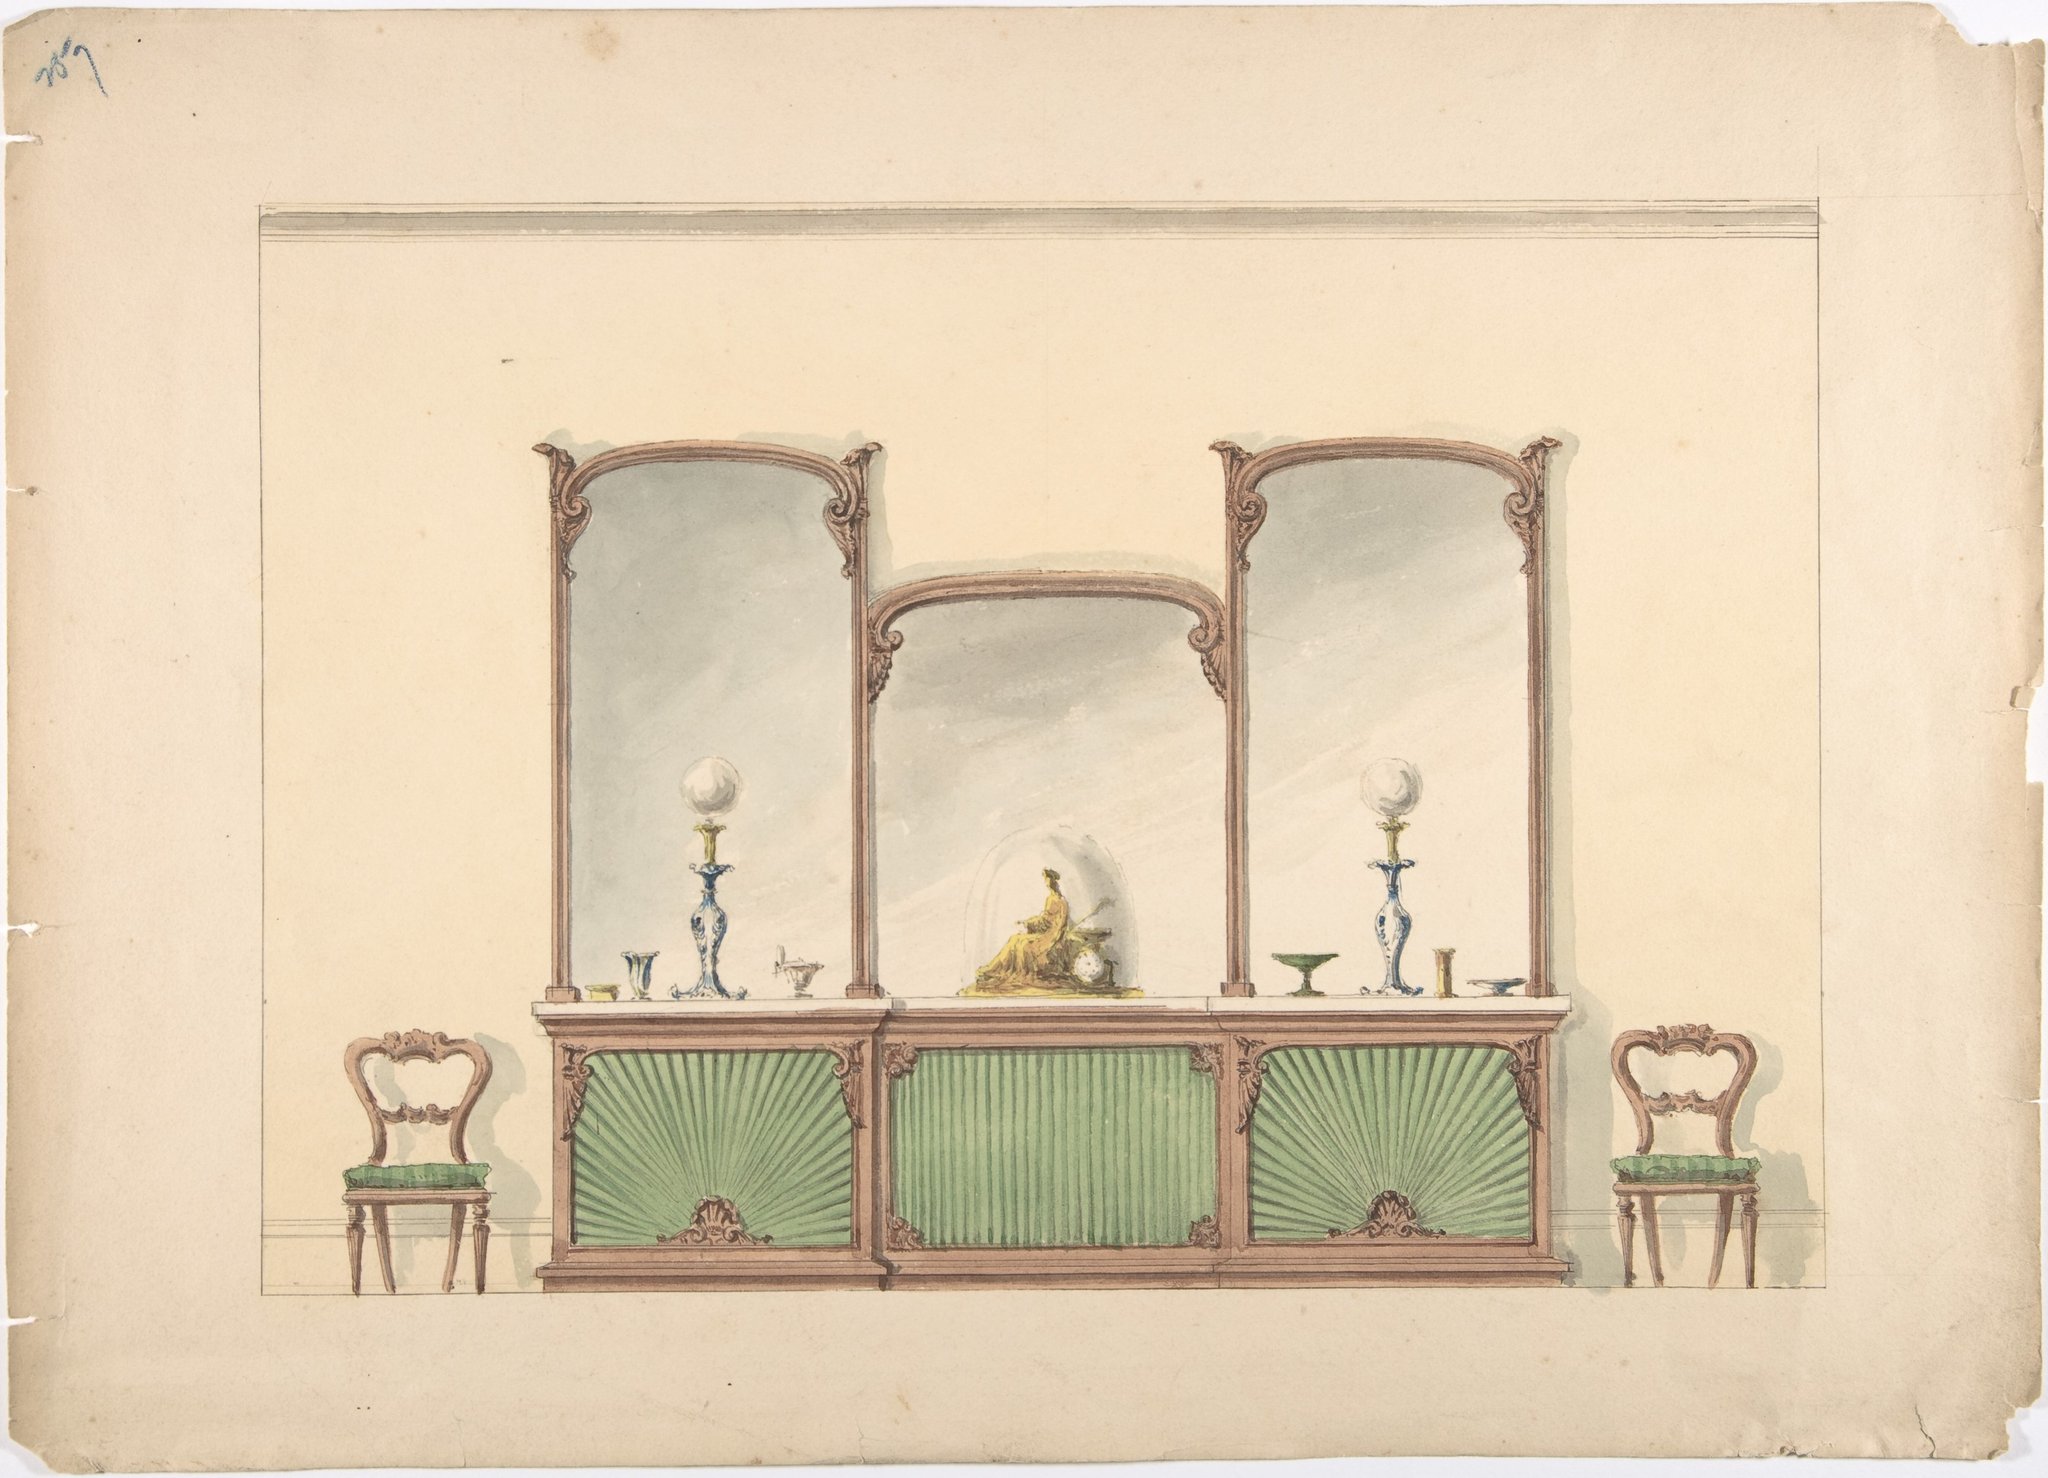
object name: drawing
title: Design for a Mirrored Three Sectioned Marble-topped Cabinet and Two Chairs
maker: anonymous, british, 19th century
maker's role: artist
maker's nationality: british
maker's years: 1800-1900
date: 1801-1833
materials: ink, watercolor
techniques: brush, pen, wash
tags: chairs,cabinets,mirrors